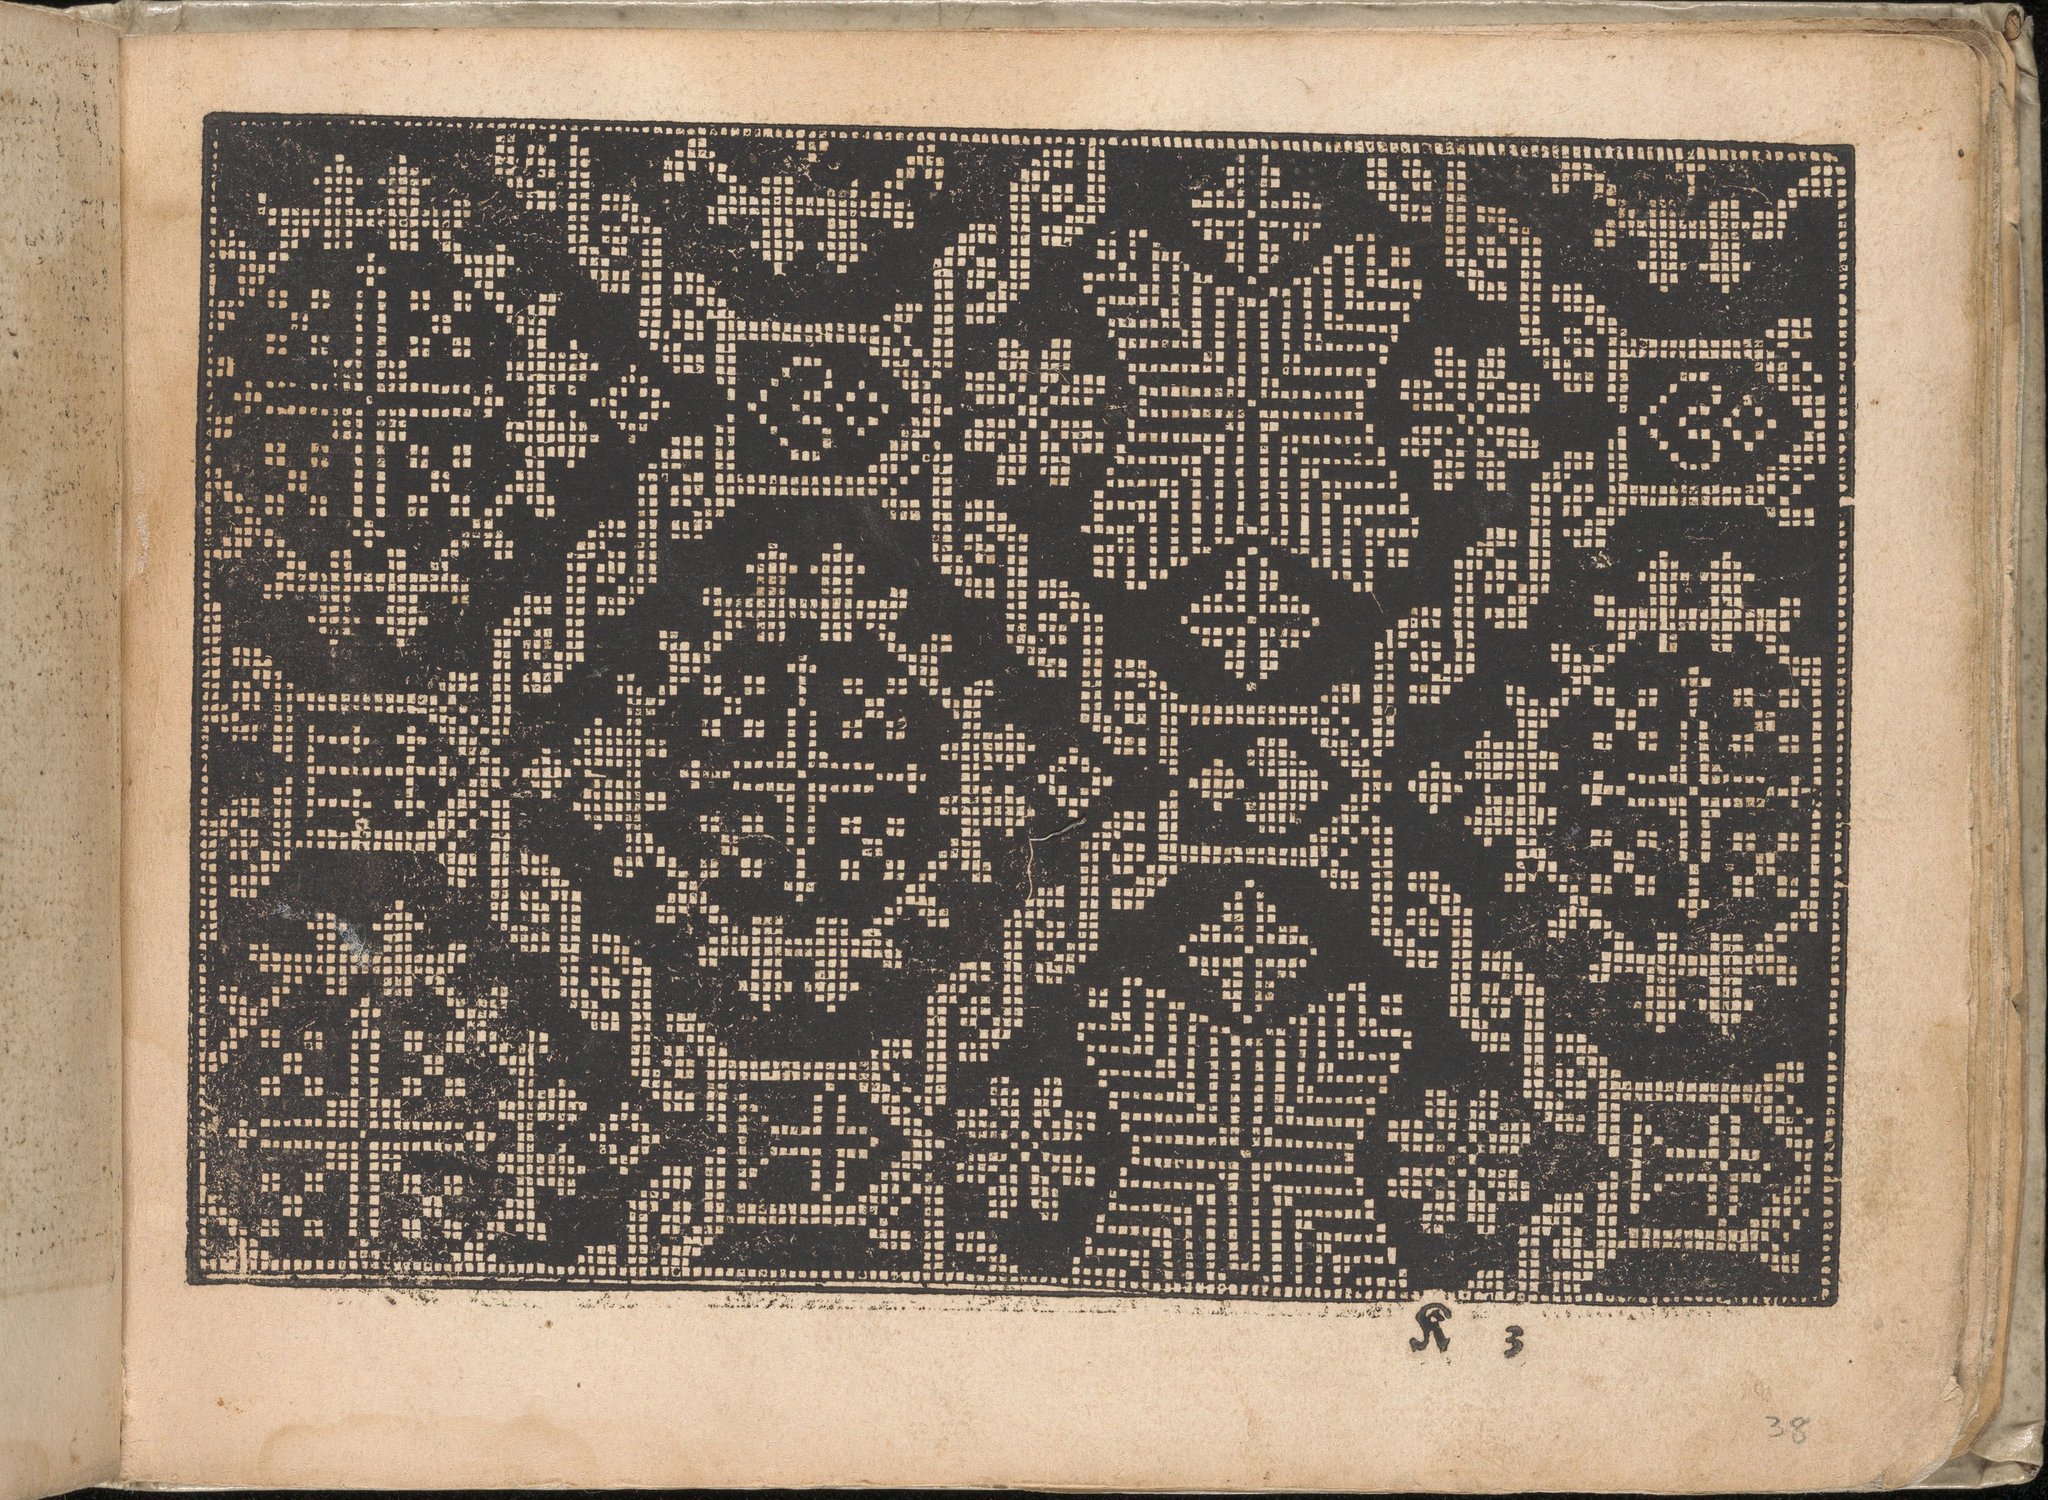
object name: book print ornament architecture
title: Neu künstlich Modelbuch (page 38r)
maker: bernhard jobin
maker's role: publisher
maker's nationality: swiss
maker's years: 1535-1597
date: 1598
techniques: woodcut